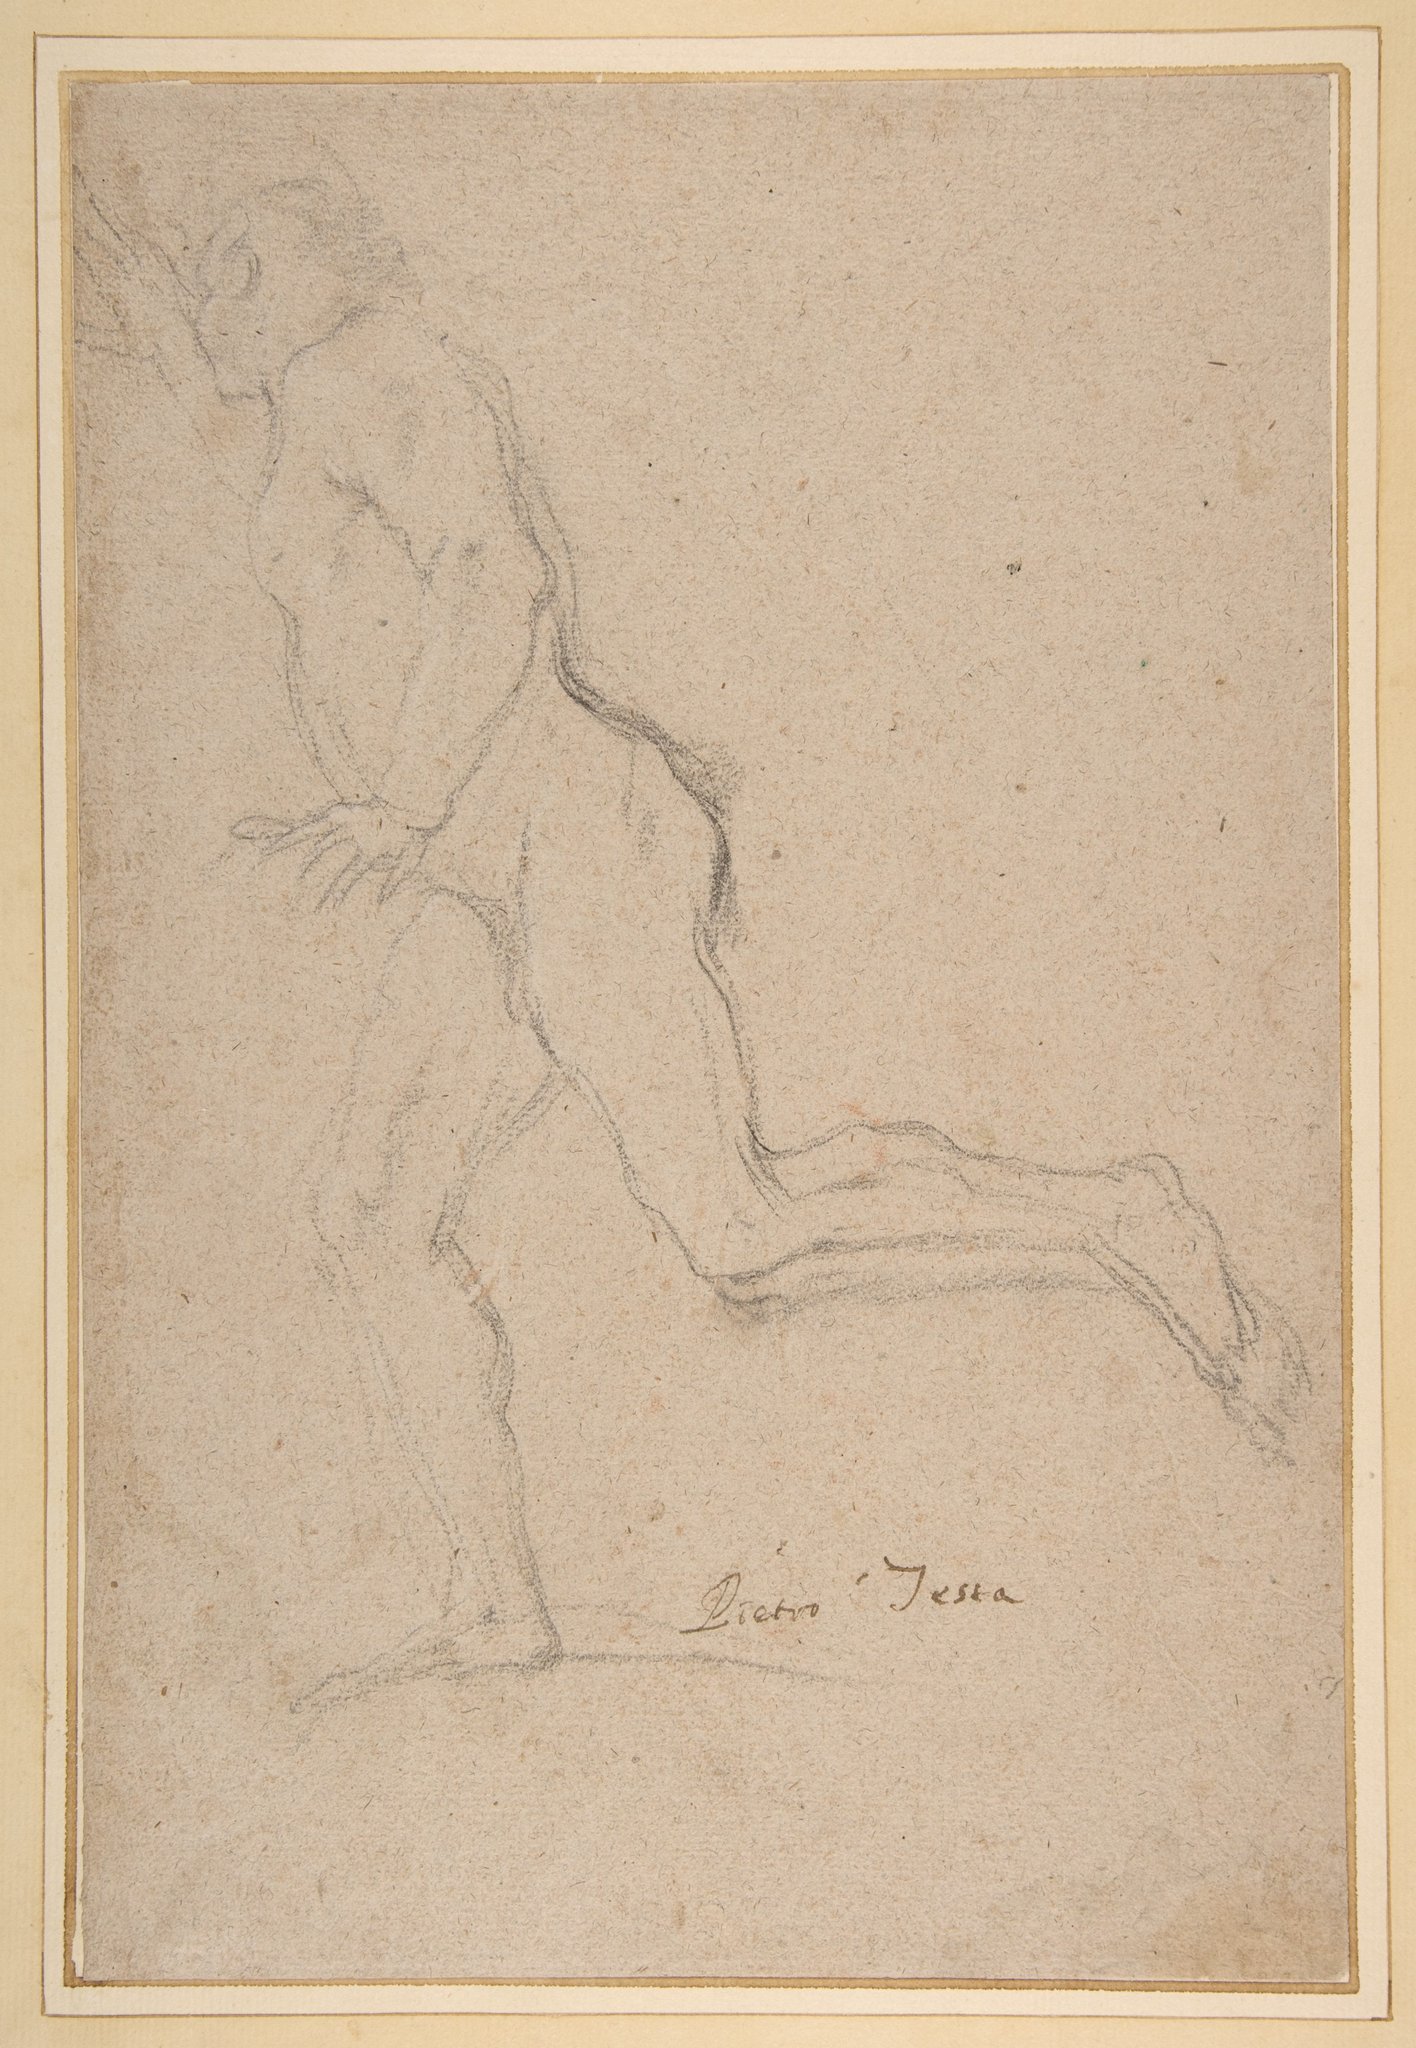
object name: drawing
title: Nude Youth Running (recto); Standing Draped Old Man with Left Hand Upraised (verso)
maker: pietro testa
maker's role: artist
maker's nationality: italian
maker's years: 1612-1650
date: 1612-1650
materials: chalk, paper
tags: male nudes,running